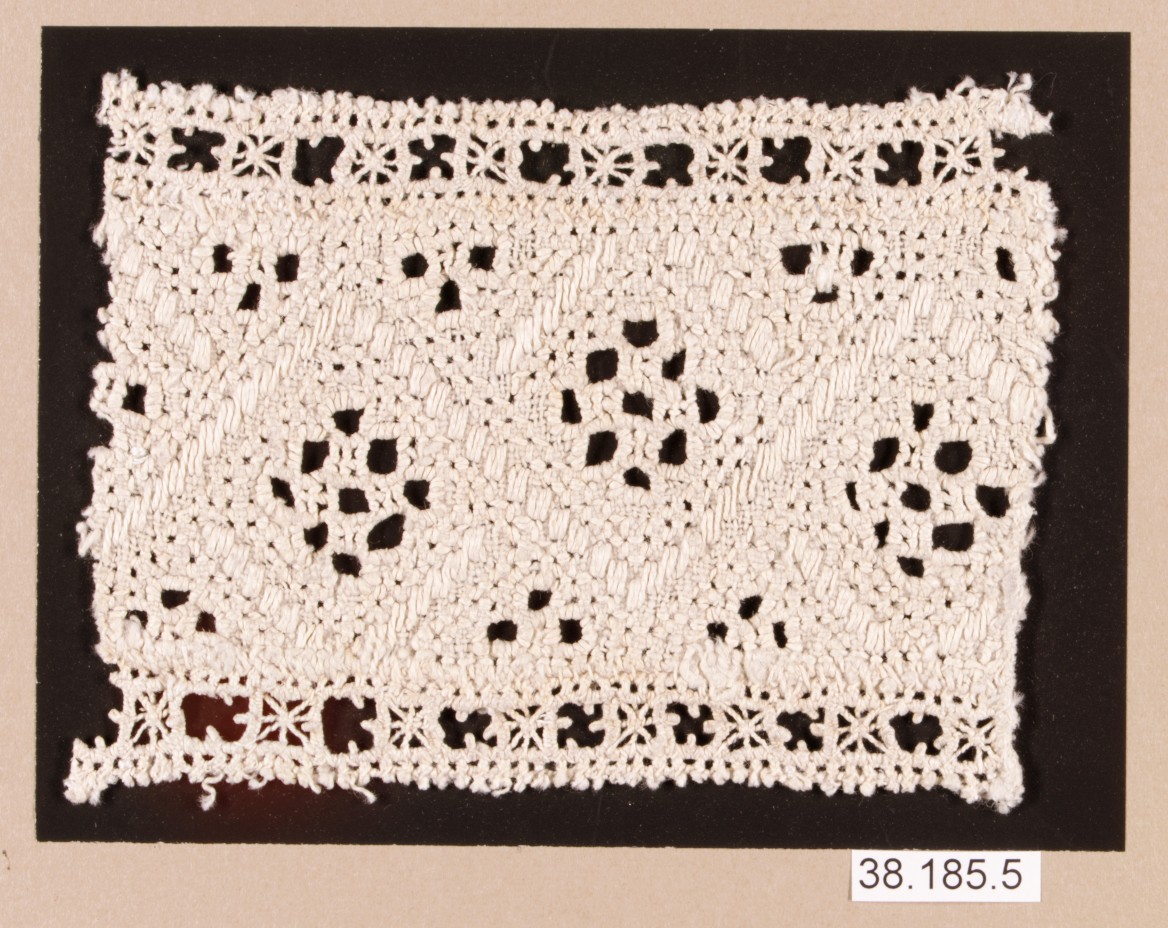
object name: insertion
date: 1501-1600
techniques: embroidery